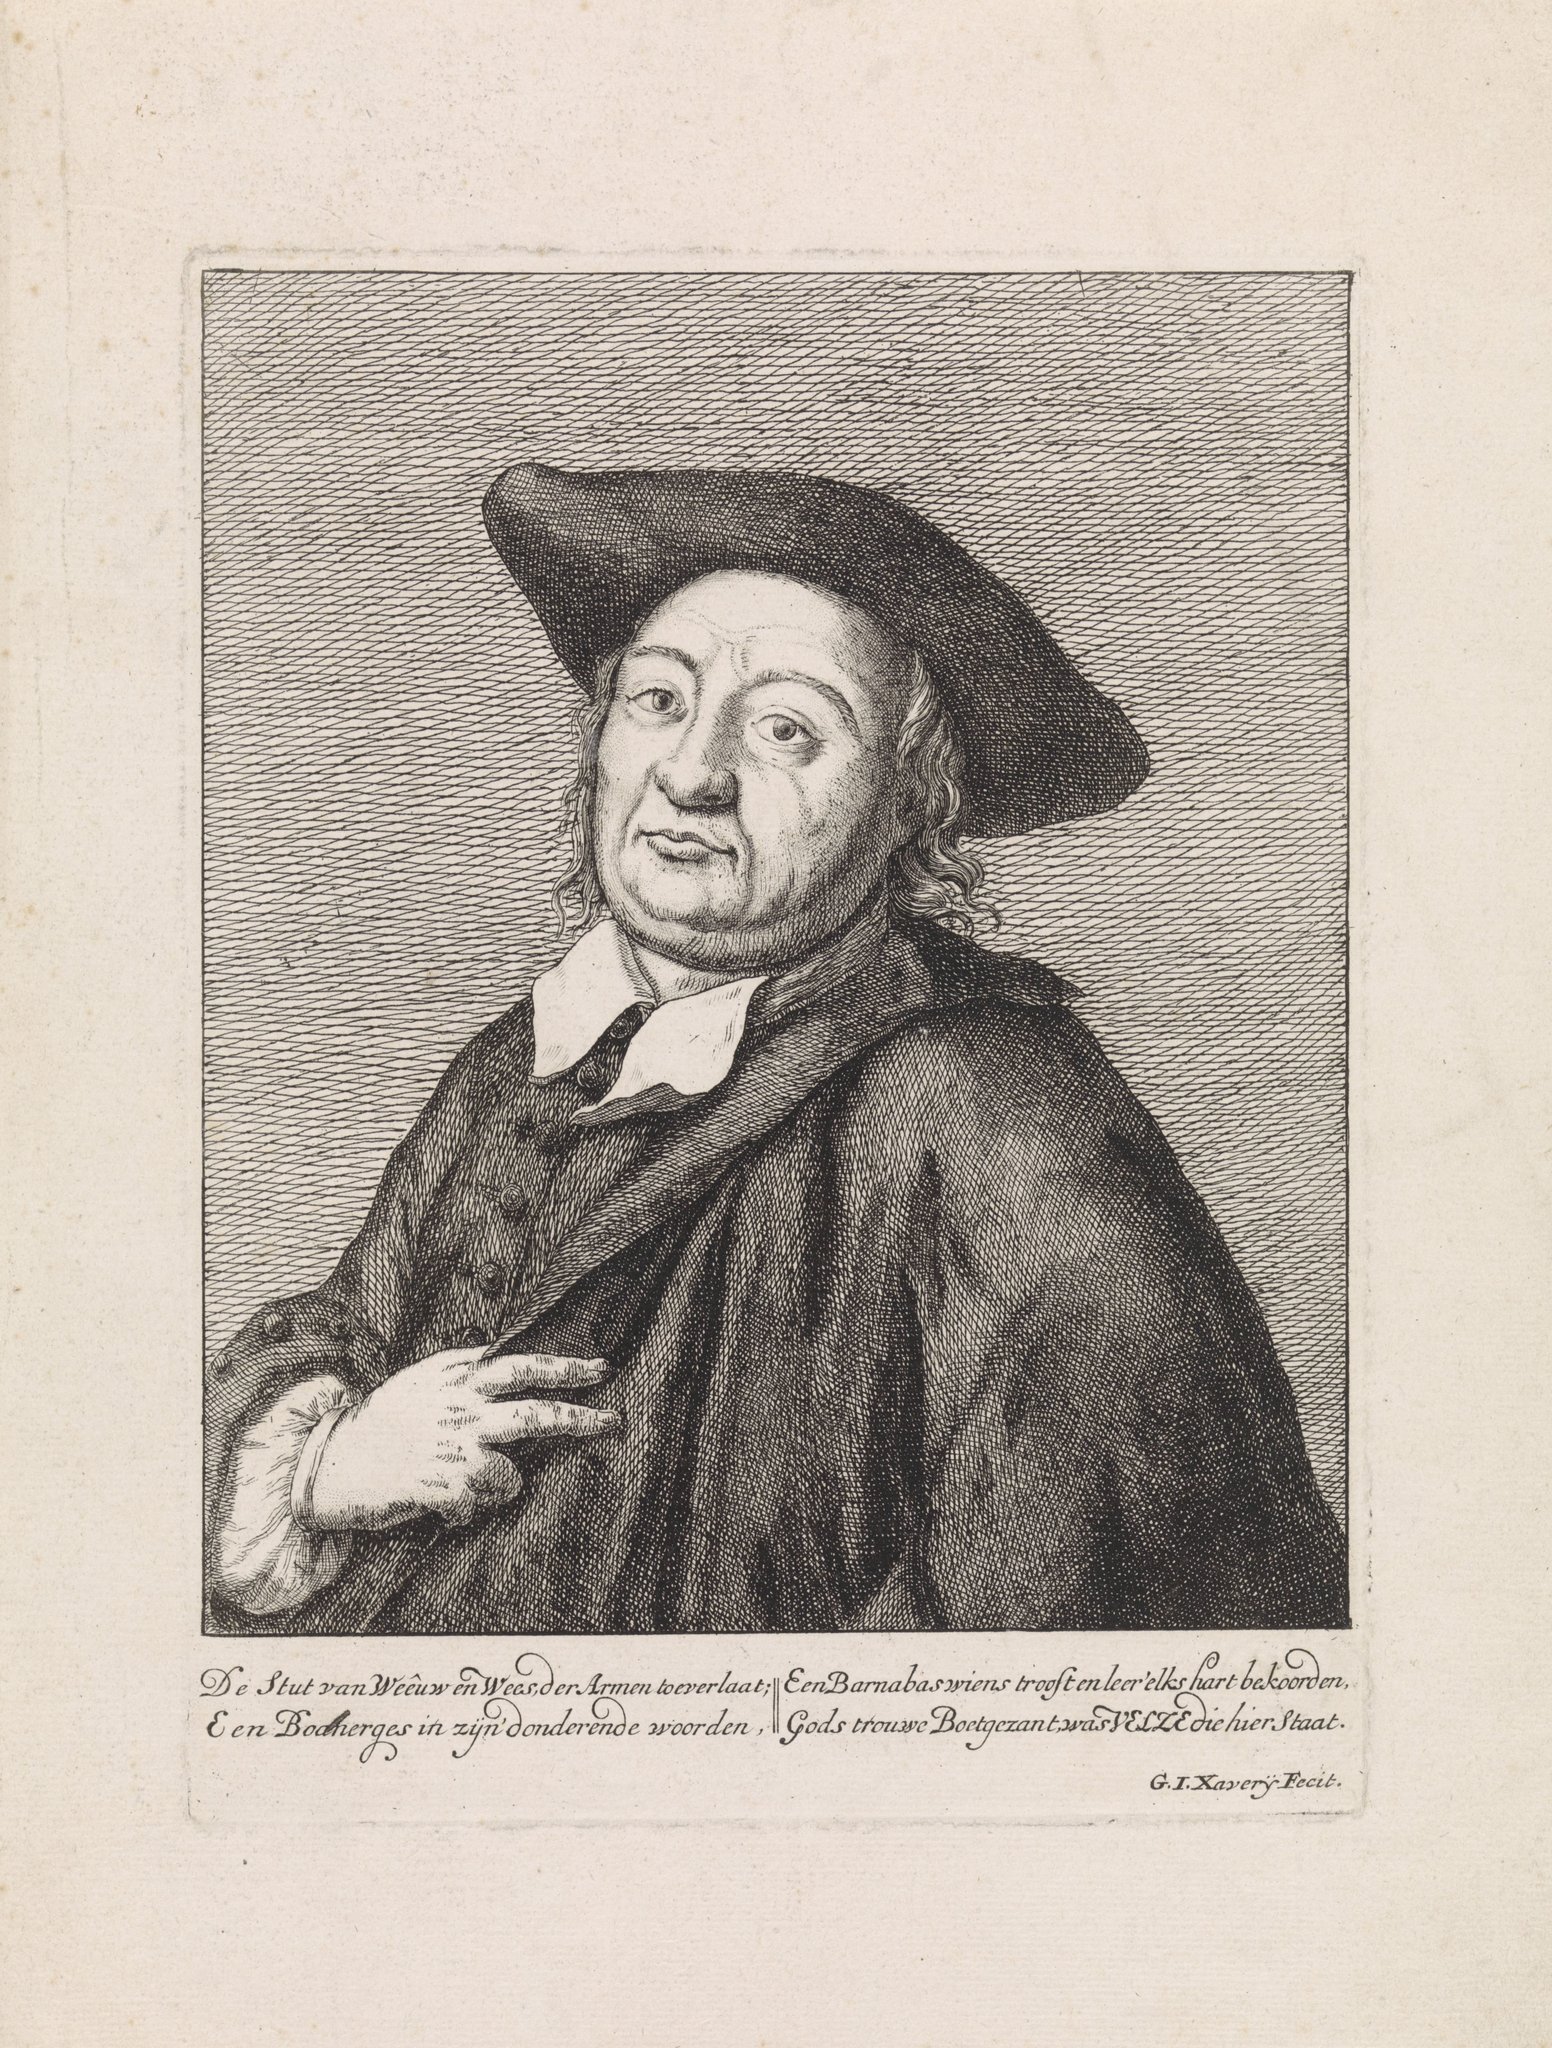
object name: print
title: Portret van Henricus Velse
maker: gerardus josephus xavery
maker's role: draughtsman, print maker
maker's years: 1700-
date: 1741-1747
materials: paper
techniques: engraving, etching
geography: the hague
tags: predikant, henricus velse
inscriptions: collector's mark: Lugt 240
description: Portret van Henricus Velse, predikant te Den Haag, met een vers in het Nederlands onderaan in de marge.